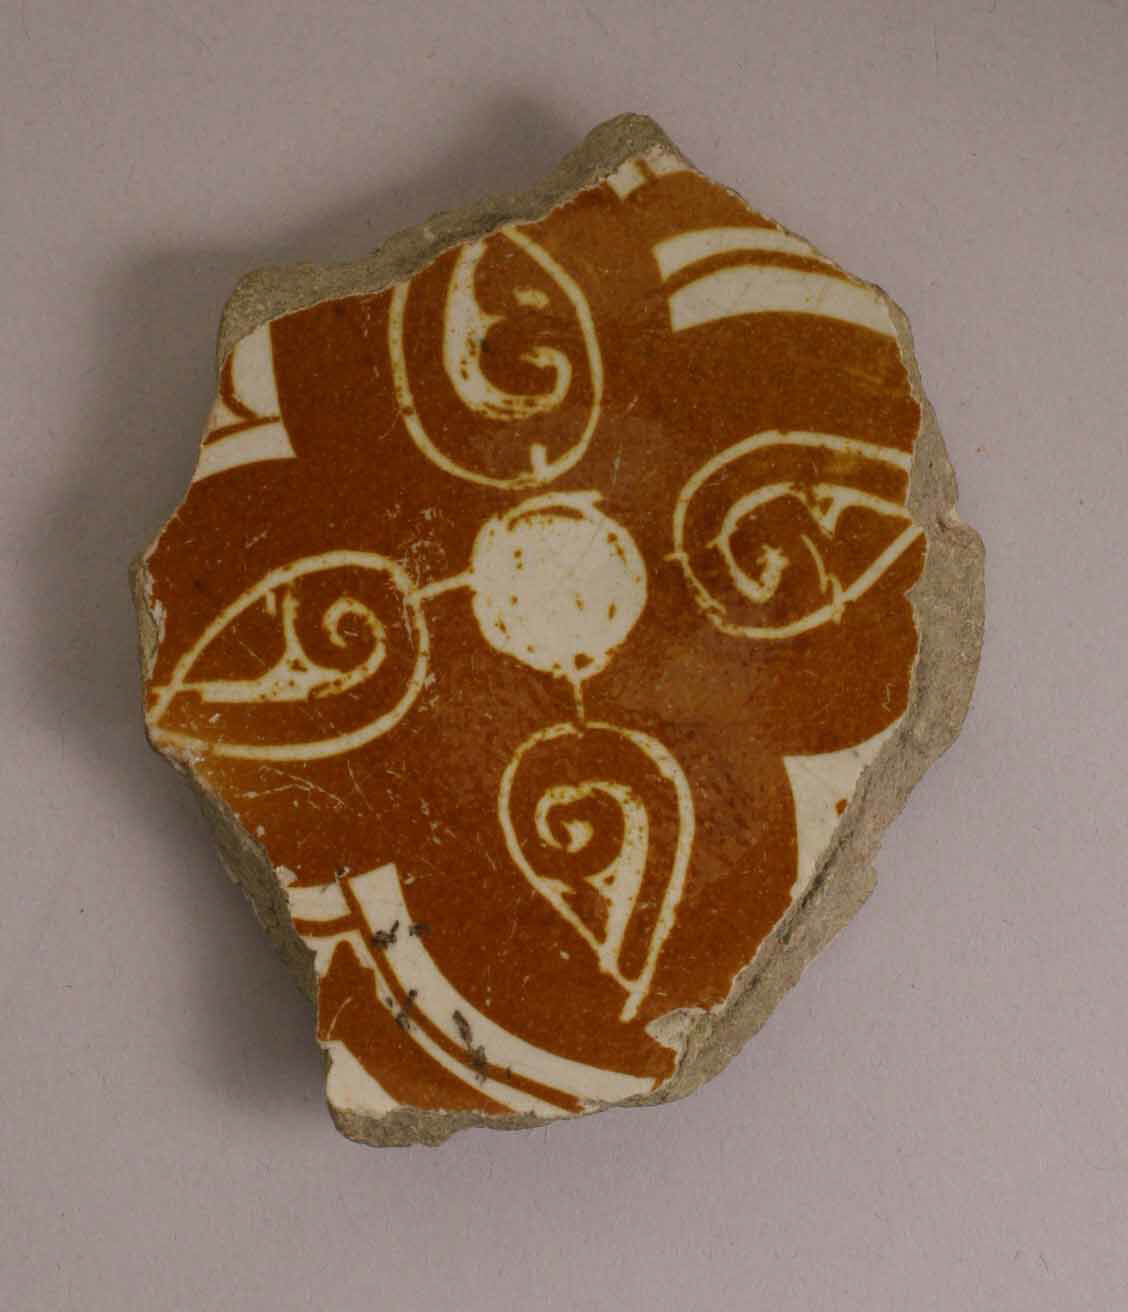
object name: fragment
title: Ceramic Fragment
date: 1201-1600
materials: glaze, stonepaste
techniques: painting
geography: egypt